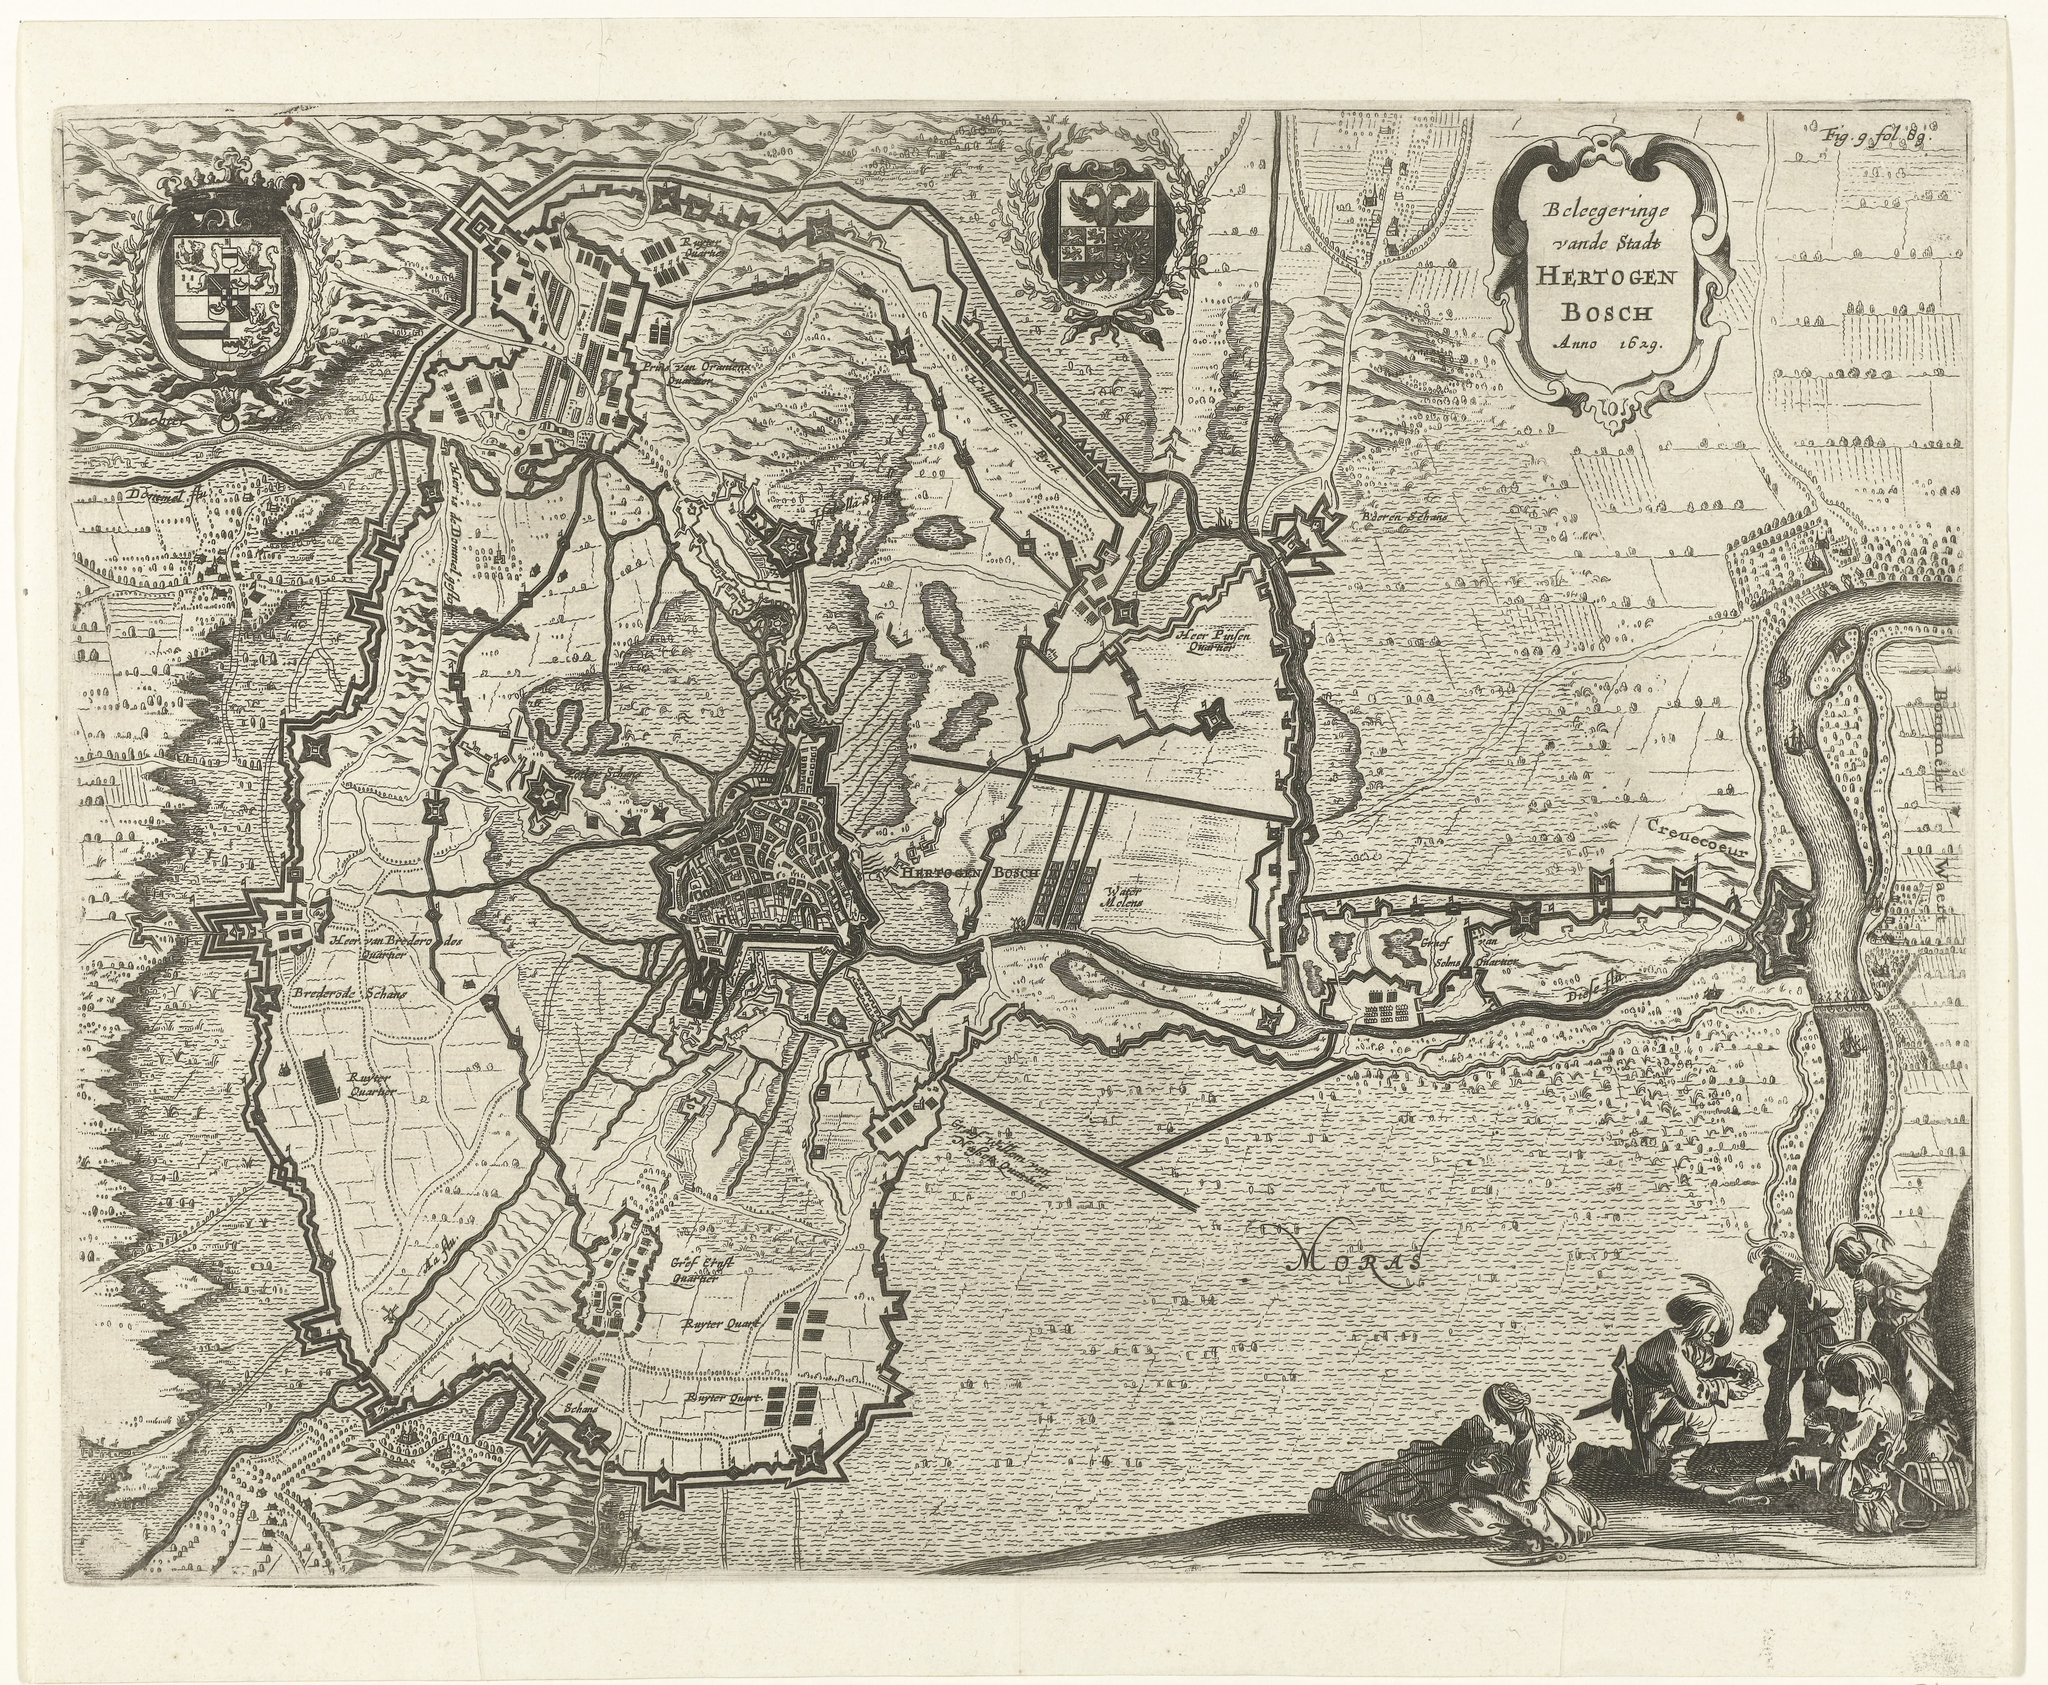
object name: print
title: Beleegeringe vande Stadt Hertogenbosch Anno 1629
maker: Anonymous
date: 1649-1651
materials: paper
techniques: etching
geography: northern netherlands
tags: delft, the hague, frederick henry (prince of orange), maps of separate countries or regions, siege, position war, den bosch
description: Kaart van het beleg van Den Bosch door het Staatse leger onder Frederik Hendrik, van 1 mei tot 17 september 1629. Kaart van Den Bosch en het omliggende gebied met de omsingeling van de stad, rechts Crèvecoeur aan de Maas. Bovenaan links het wapen van Frederik Hendrik, in het midden het wapen van de stad. Rechtsonder kaartende soldaten. Gemerkt rechtsboven Fig. 9 fol 89.